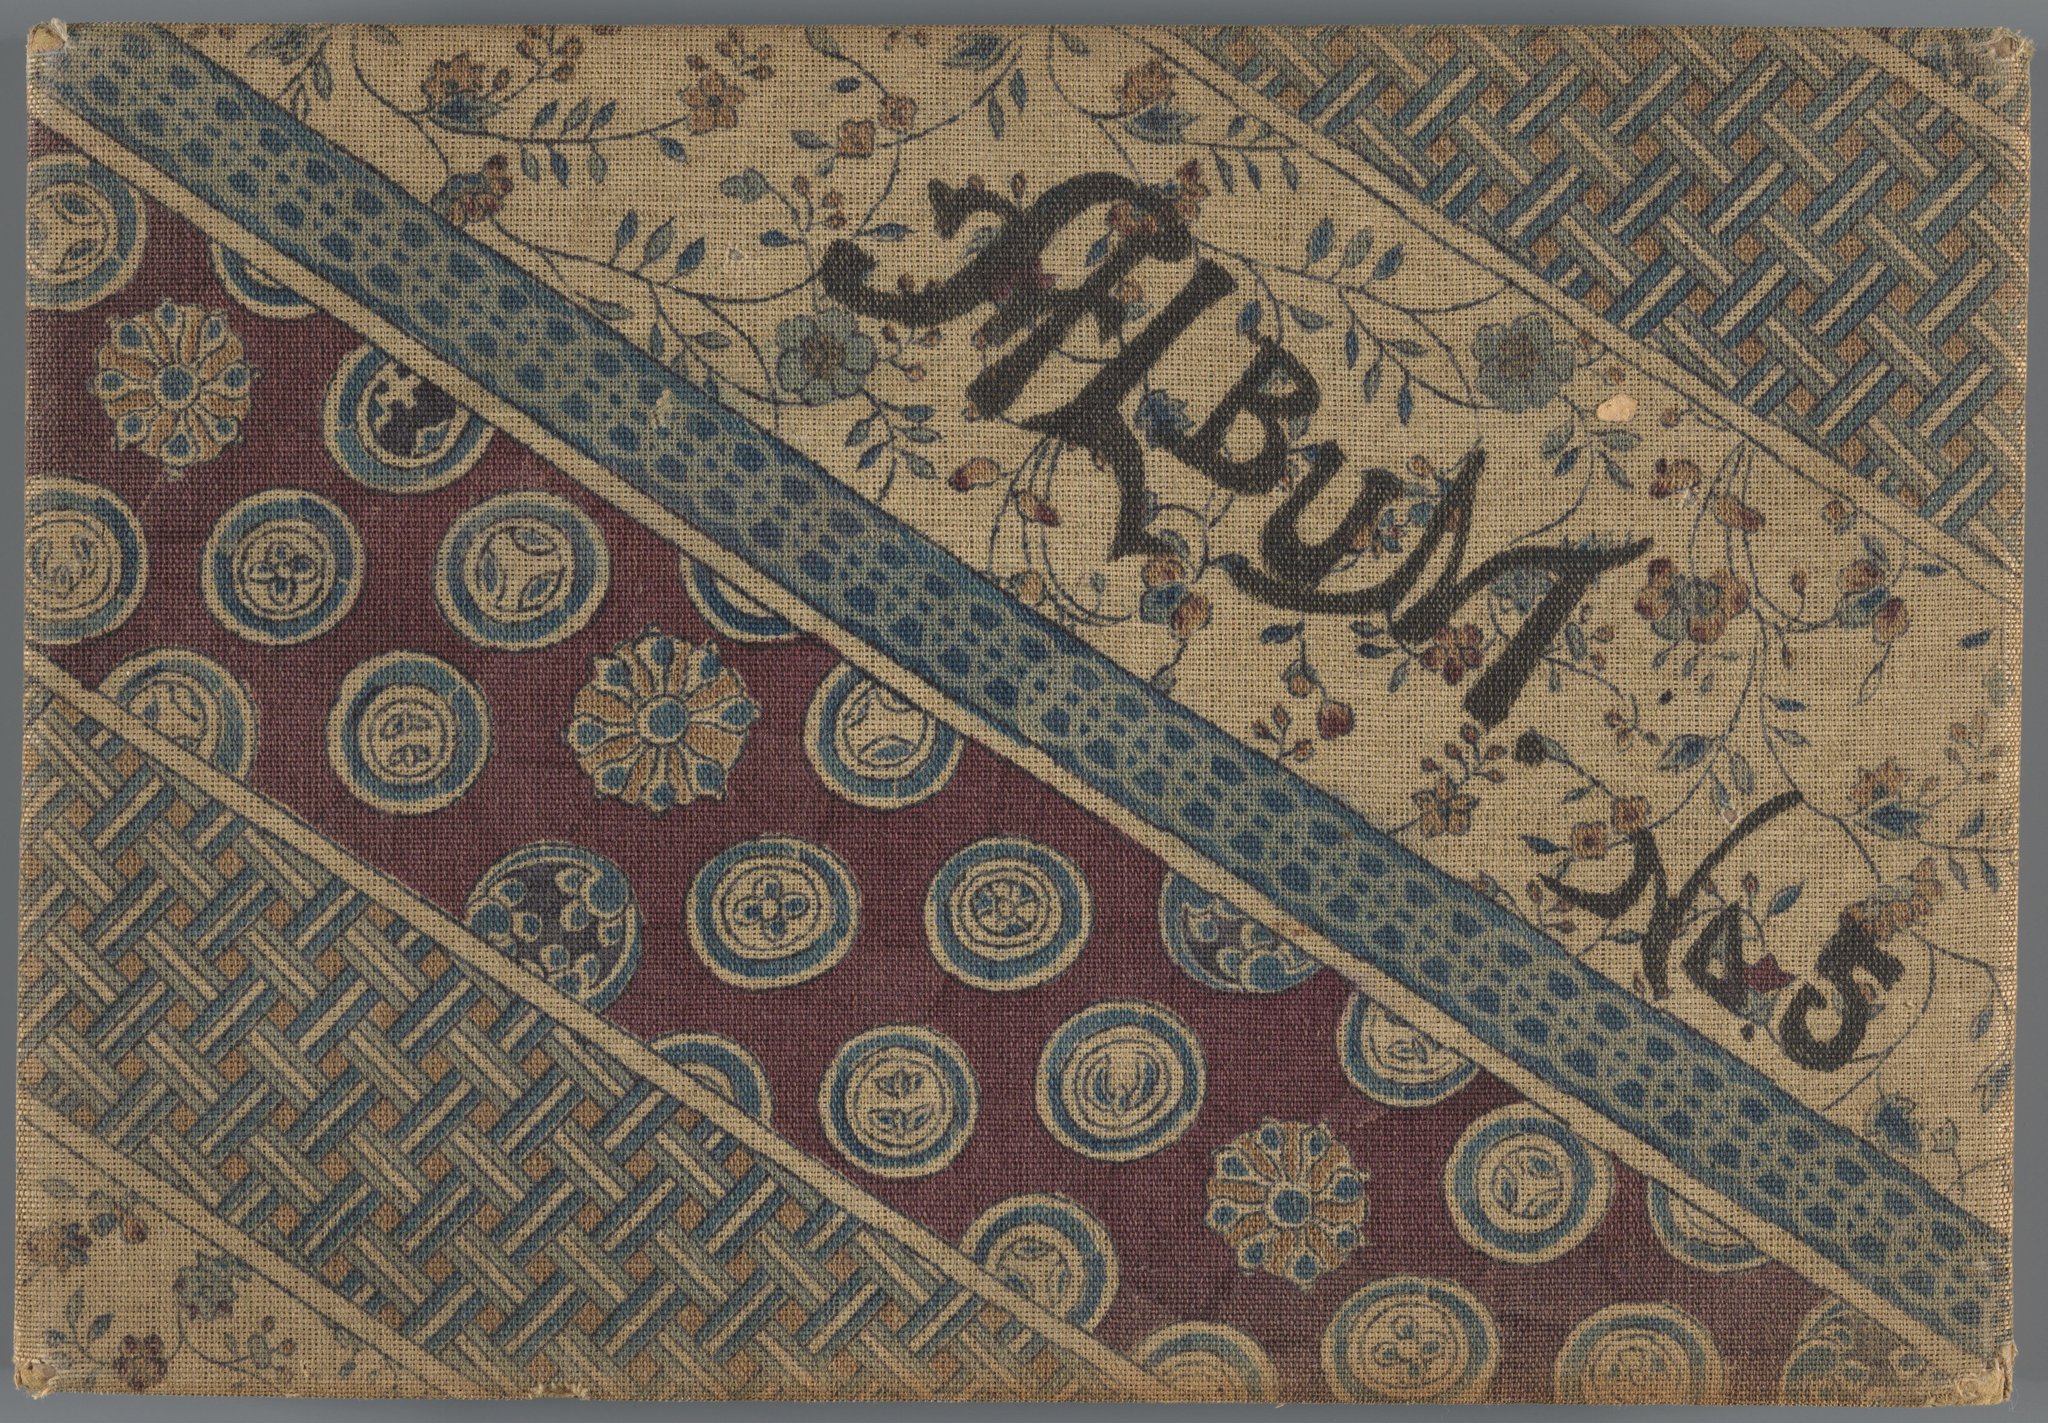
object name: photograph album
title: Fotoalbum met foto's van 'Het leven in het leger' (guntai seikatsu)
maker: Anonymous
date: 1930-1940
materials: cardboard, paper, photographic support, textile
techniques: gelatin silver print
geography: japan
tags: the soldier; the soldier's life, japan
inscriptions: title: ‘guntai seikatsu’, title: ‘Album No. 5’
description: Het leporello fotoalbum bevat dertien bladzijden met in totaal 46 foto’s van de diensttijd van Japanse militairen, plus twee losse inliggende foto’s. Het album is bekleed met bedrukte stof waarop een handgeschreven opschrift 'Album No. 5.